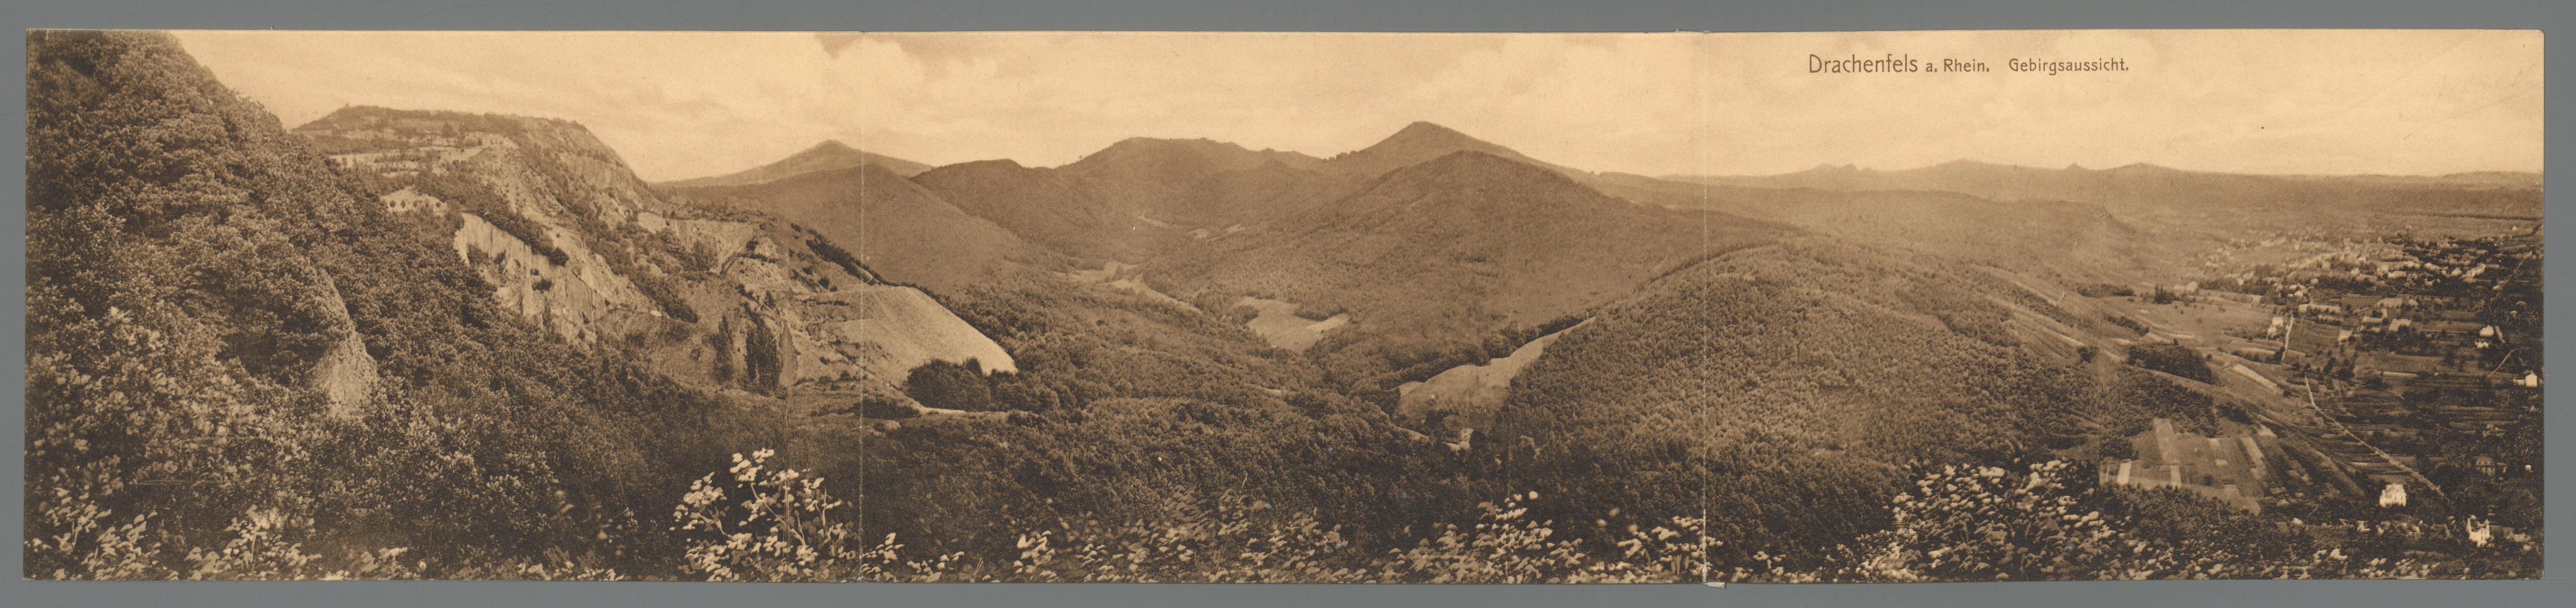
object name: photomechanical print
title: Drachenfels a. Rhein. Gebirgsaussicht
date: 1885-1905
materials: cardboard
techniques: photograph, writing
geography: barmen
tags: dale, valley, city-view, and landscape with man-made constructions, mountains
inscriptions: poststempel, verso, gestempeld